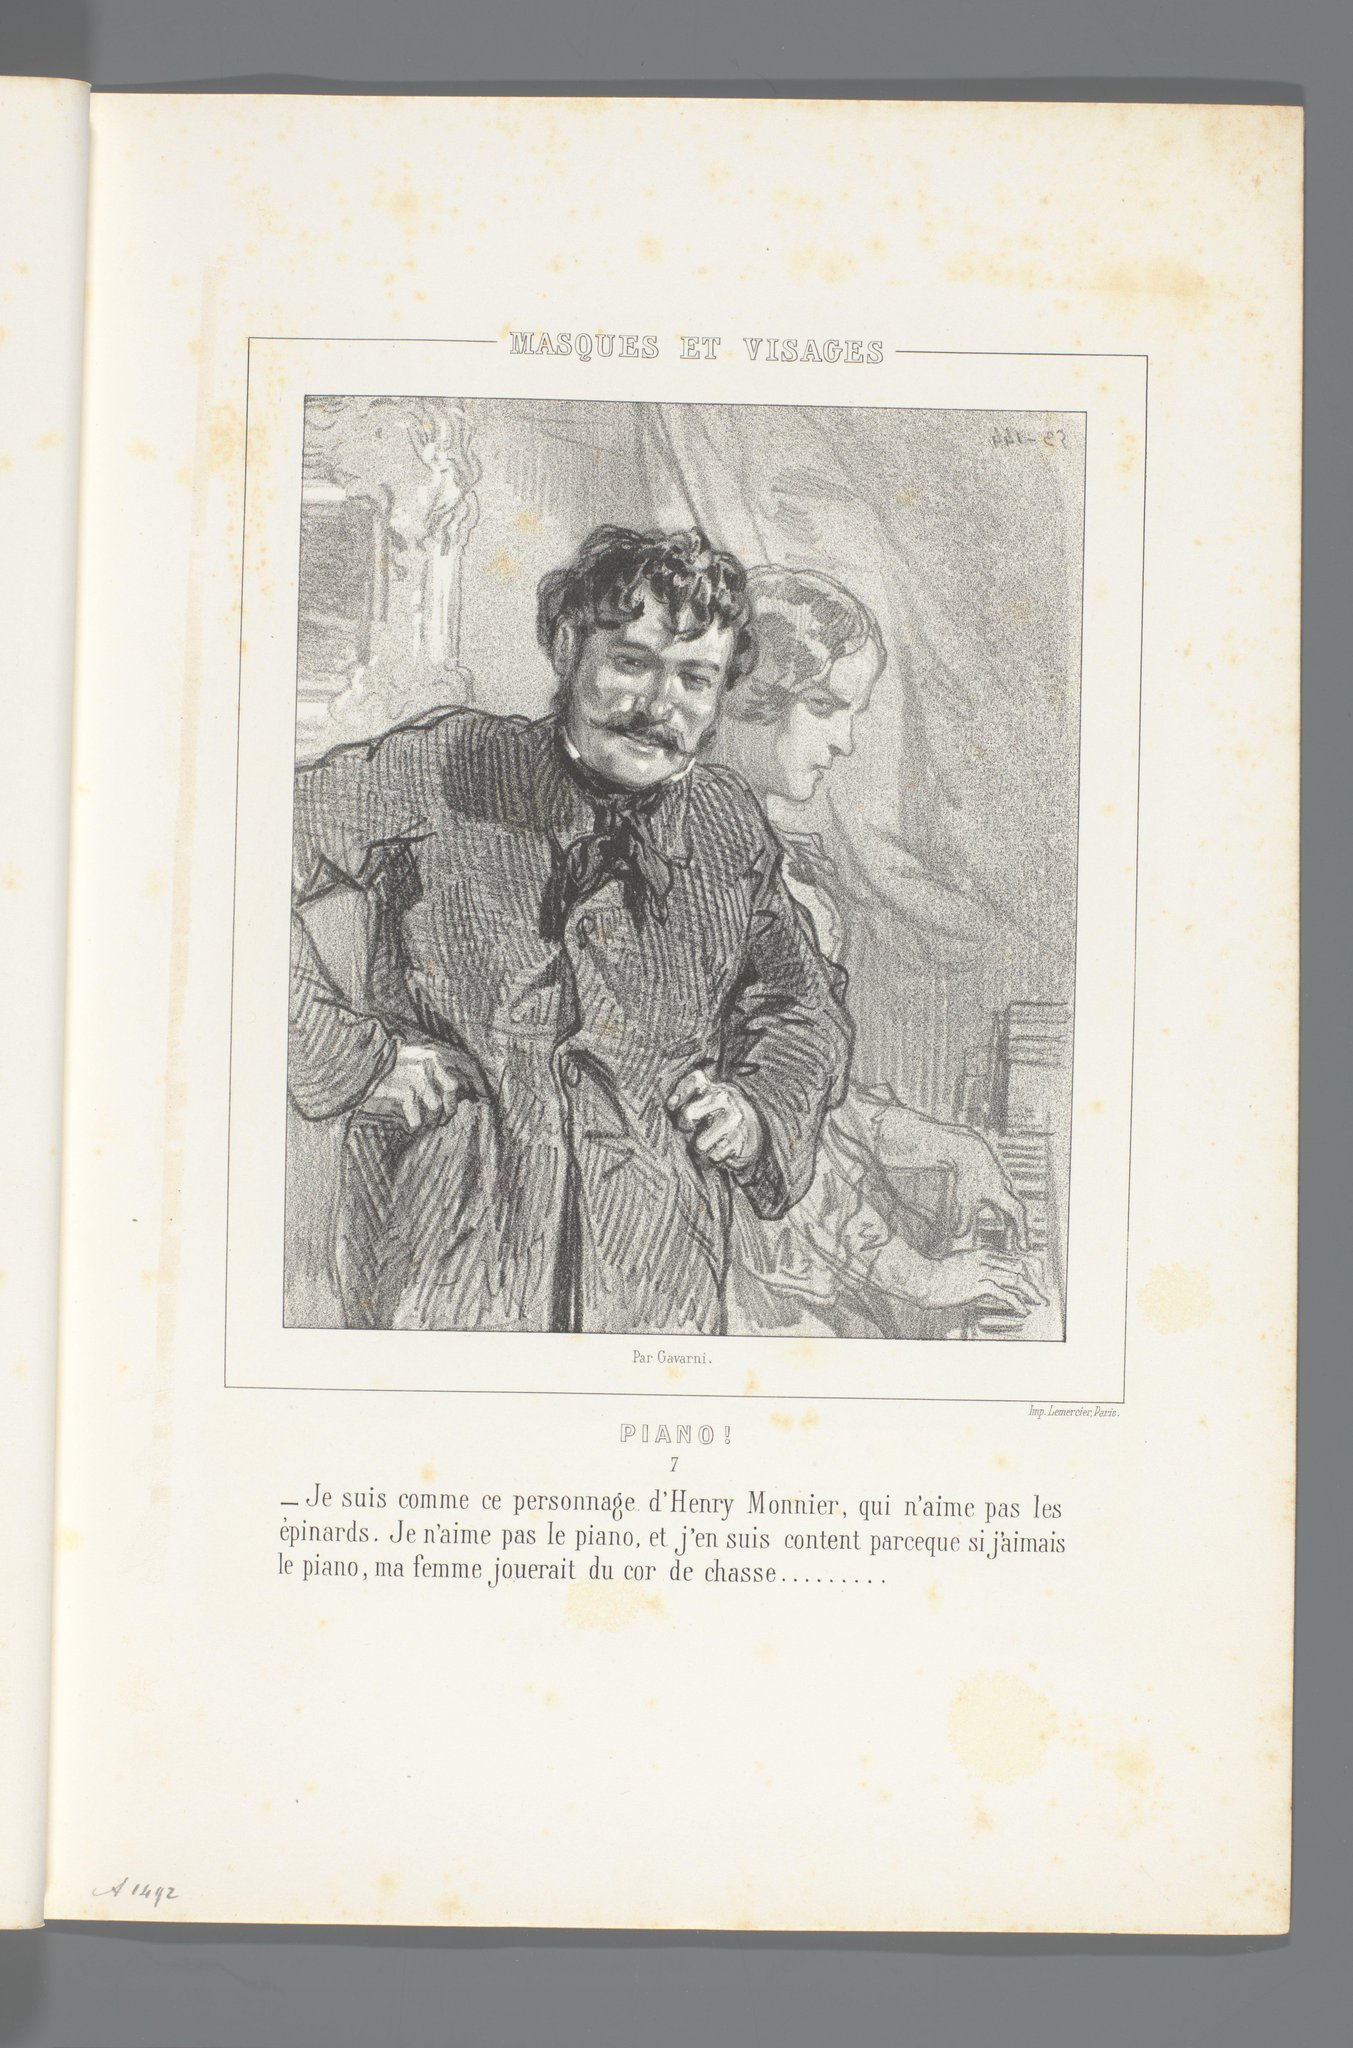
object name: album leaf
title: Je suis comme ce personnage d'Henry Monnier (...)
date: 1853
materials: paper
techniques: lithograph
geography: paris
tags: one person playing keyboard instrument, satire on marriage, pianoforte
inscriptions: collector's mark: Lugt 964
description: Prent gebruikt voor: Paris (journal), 8 juli 1853.